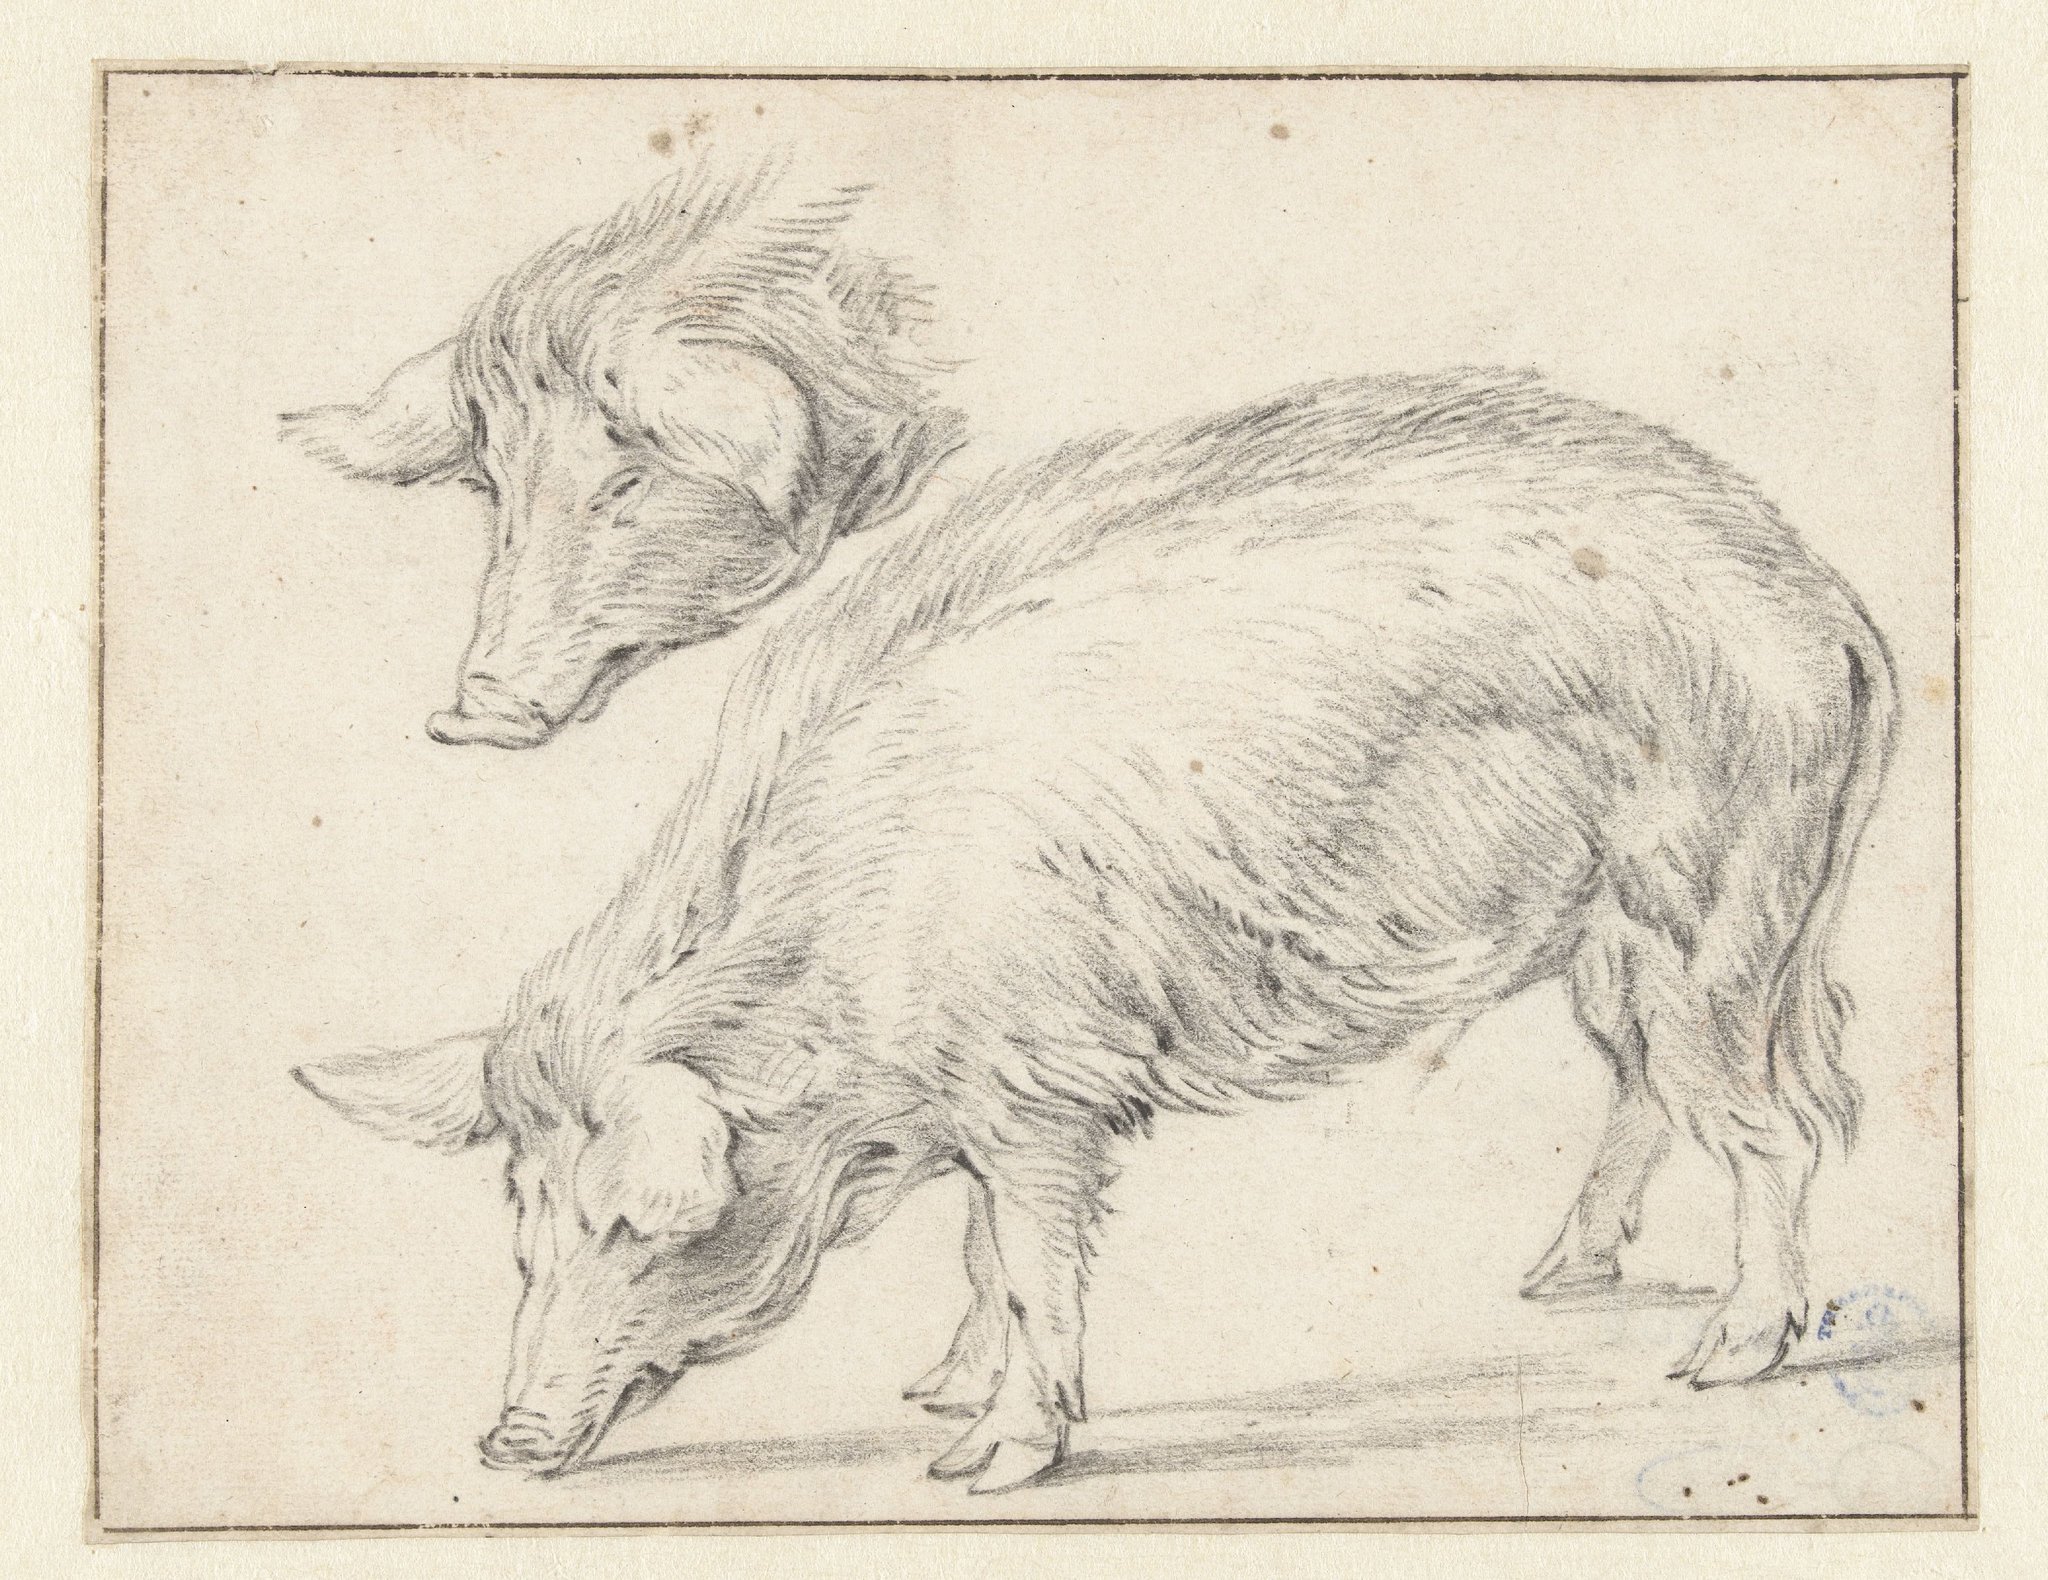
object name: drawing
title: Two Studies of a Pig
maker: simon de vlieger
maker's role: draughtsman, painter, print maker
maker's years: 1600-1653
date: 1630-1653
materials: chalk, paper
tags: pig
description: Hailing from Rotterdam, Simon de Vlieger was foremost a landscape and marine painter, but he occasionally also drew the animals he came across on his outdoor excursions. This drawing shows a pig from the side, and an alternative study of its head, seen more from the front. He also made various prints featuring pigs, ducks, cats and dogs.